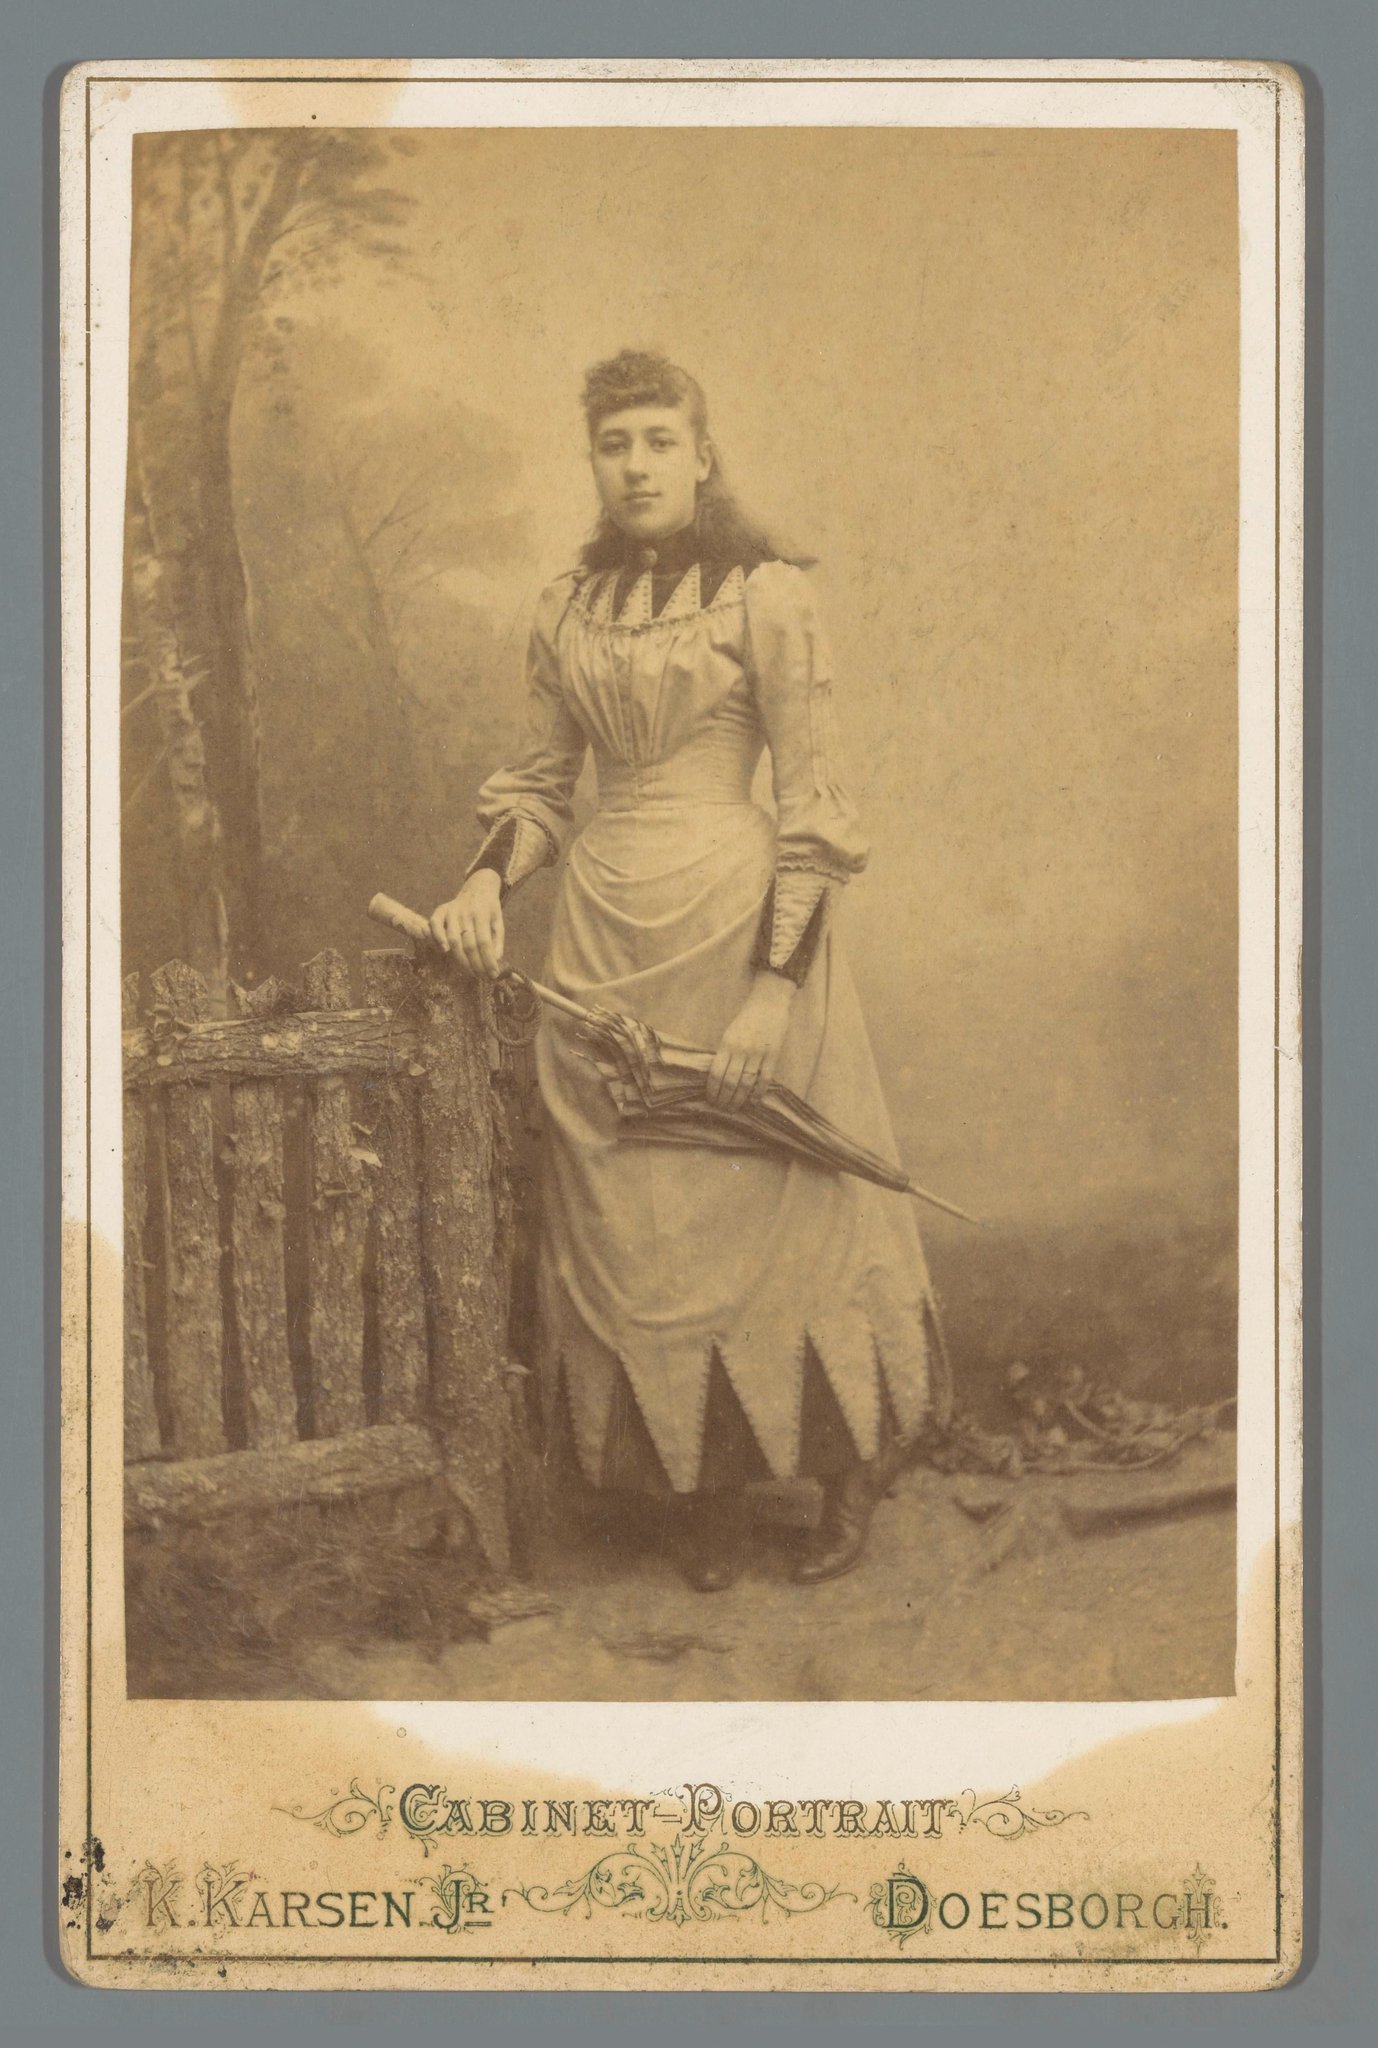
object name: cabinet photograph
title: Portret van een onbekende vrouw met een paraplu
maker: kars karsen jr.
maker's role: fotograaf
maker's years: 1852-1935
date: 1875-1905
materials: cardboard, photographic support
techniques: albumen print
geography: doesburg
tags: adult woman, umbrella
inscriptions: name: ‘K. Karsen Jr. Photograaf Veerpoortstraat Doesburg (...)’